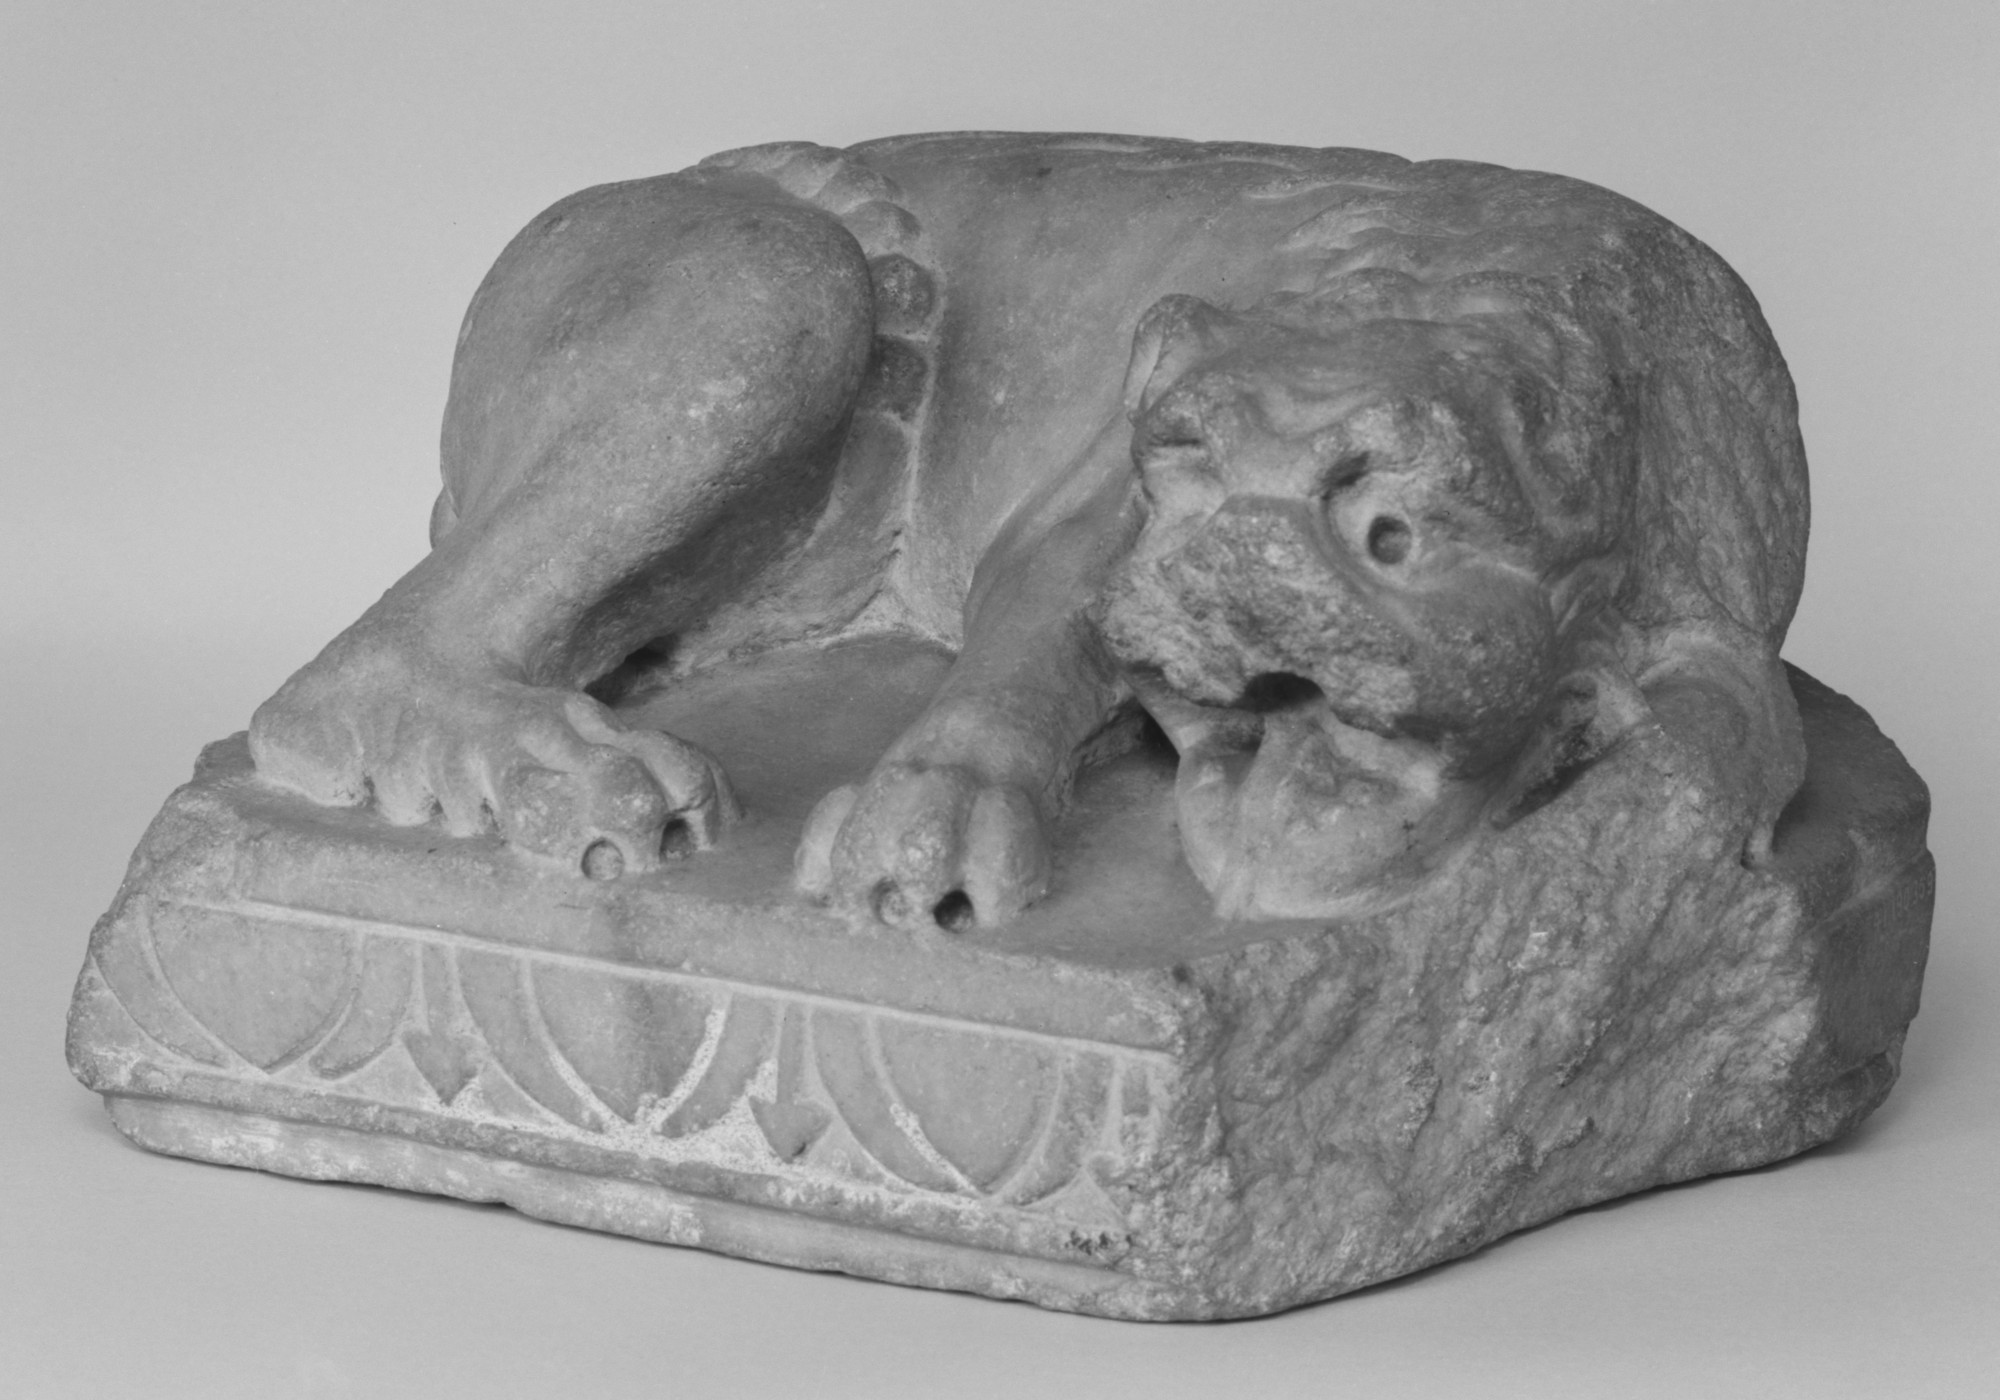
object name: statuette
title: Reclining lion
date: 1501-1600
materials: marble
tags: lions